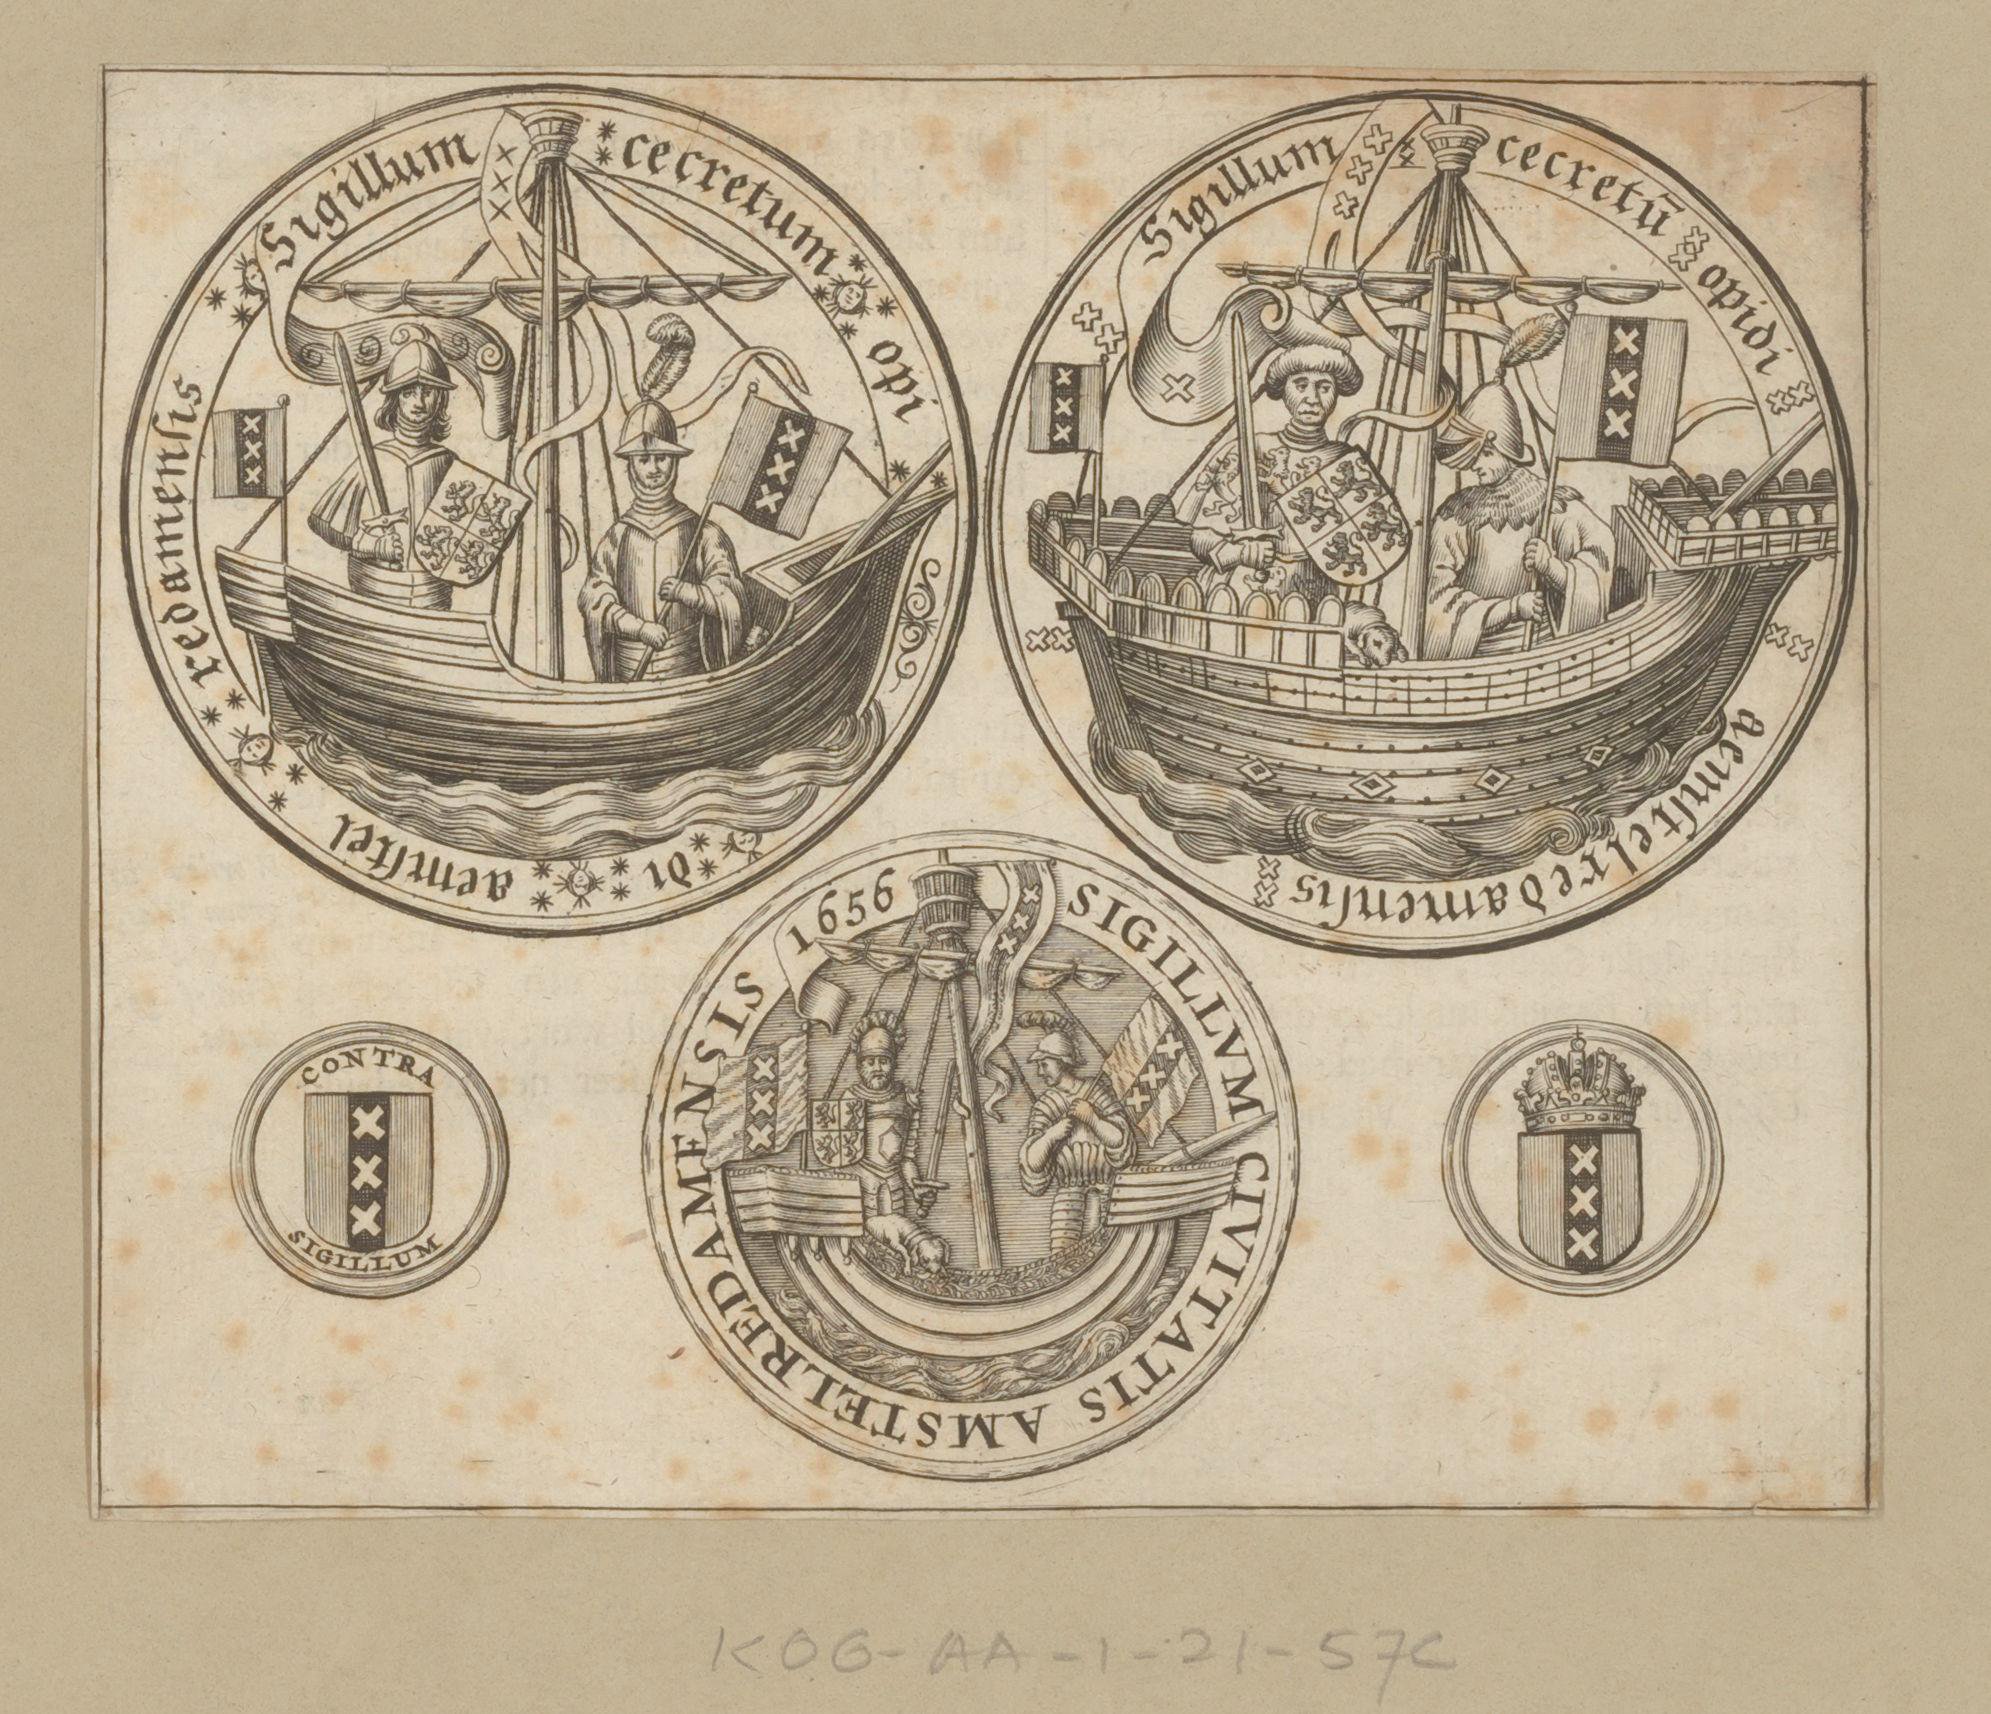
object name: book illustration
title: Vijf zegels van Amsterdam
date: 1693-1694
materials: paper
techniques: engraving, letterpress printing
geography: amsterdam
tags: crown (symbol of sovereignty), seal, stamp, seal (as symbol of the state, etc.), amsterdam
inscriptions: collector's mark: Lugt 1641b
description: Prent uit: Commelin, Caspar. Beschryvinge van Amsterdam, zynde een naukeurige verhandelinge van desselfs eerste oorspronk uyt den huyse der heeren van Amstel, en Amstellant, haar vergrooting, rykdom, en wyze van regeeringe, tot den jare 1691. 2 dln. Amsterdam: weduwe Aart Dircksz Oossaan, 1694, dl. 1, p. 183.